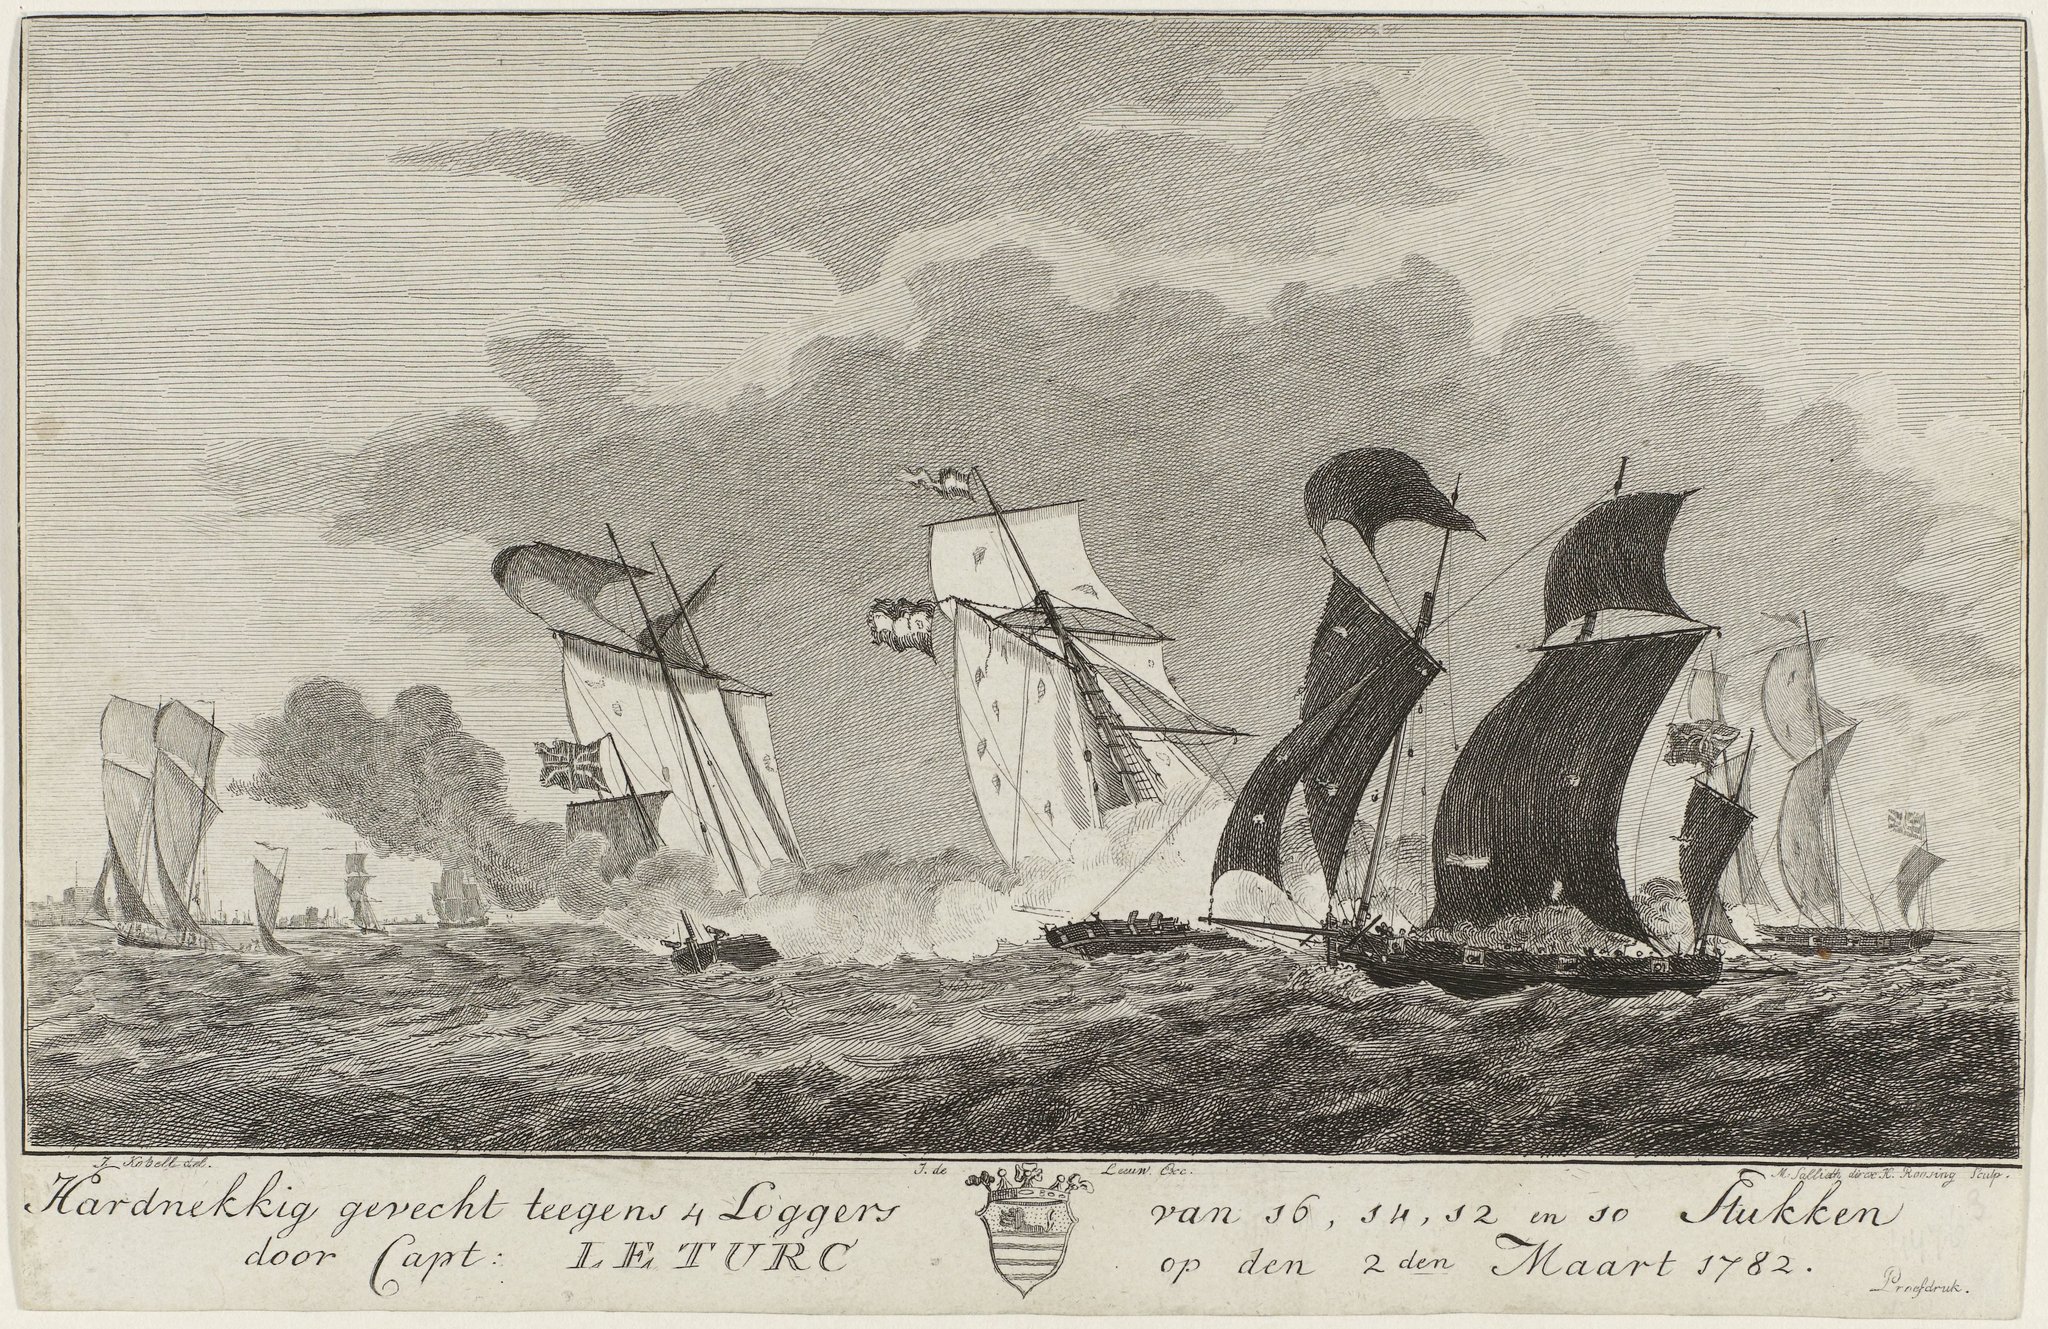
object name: print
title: Hardnekkig gevecht teegens 4 Loggers van 16, 14, 12 en 10 Stukken door Capt: Le Turc op den 2den Maart 1782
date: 1782-1784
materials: paper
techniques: engraving, etching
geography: rotterdam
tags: capuche, battle (+ naval force), fourth anglo-dutch war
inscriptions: collector's mark: Lugt 2228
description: Gevecht van de kaperkapitein Pierre le Turcq met het schip de Vlissinger voor de Engelse kust met Britse loggers, 2 maart 1782. Onderdeel van een groep van vijf illustraties van de veroveringen door Pierre le Turcq in 1782. In de marge de titel met in het midden het wapen van Zeeland. Gemerkt rechtsonder: Proefdruk.